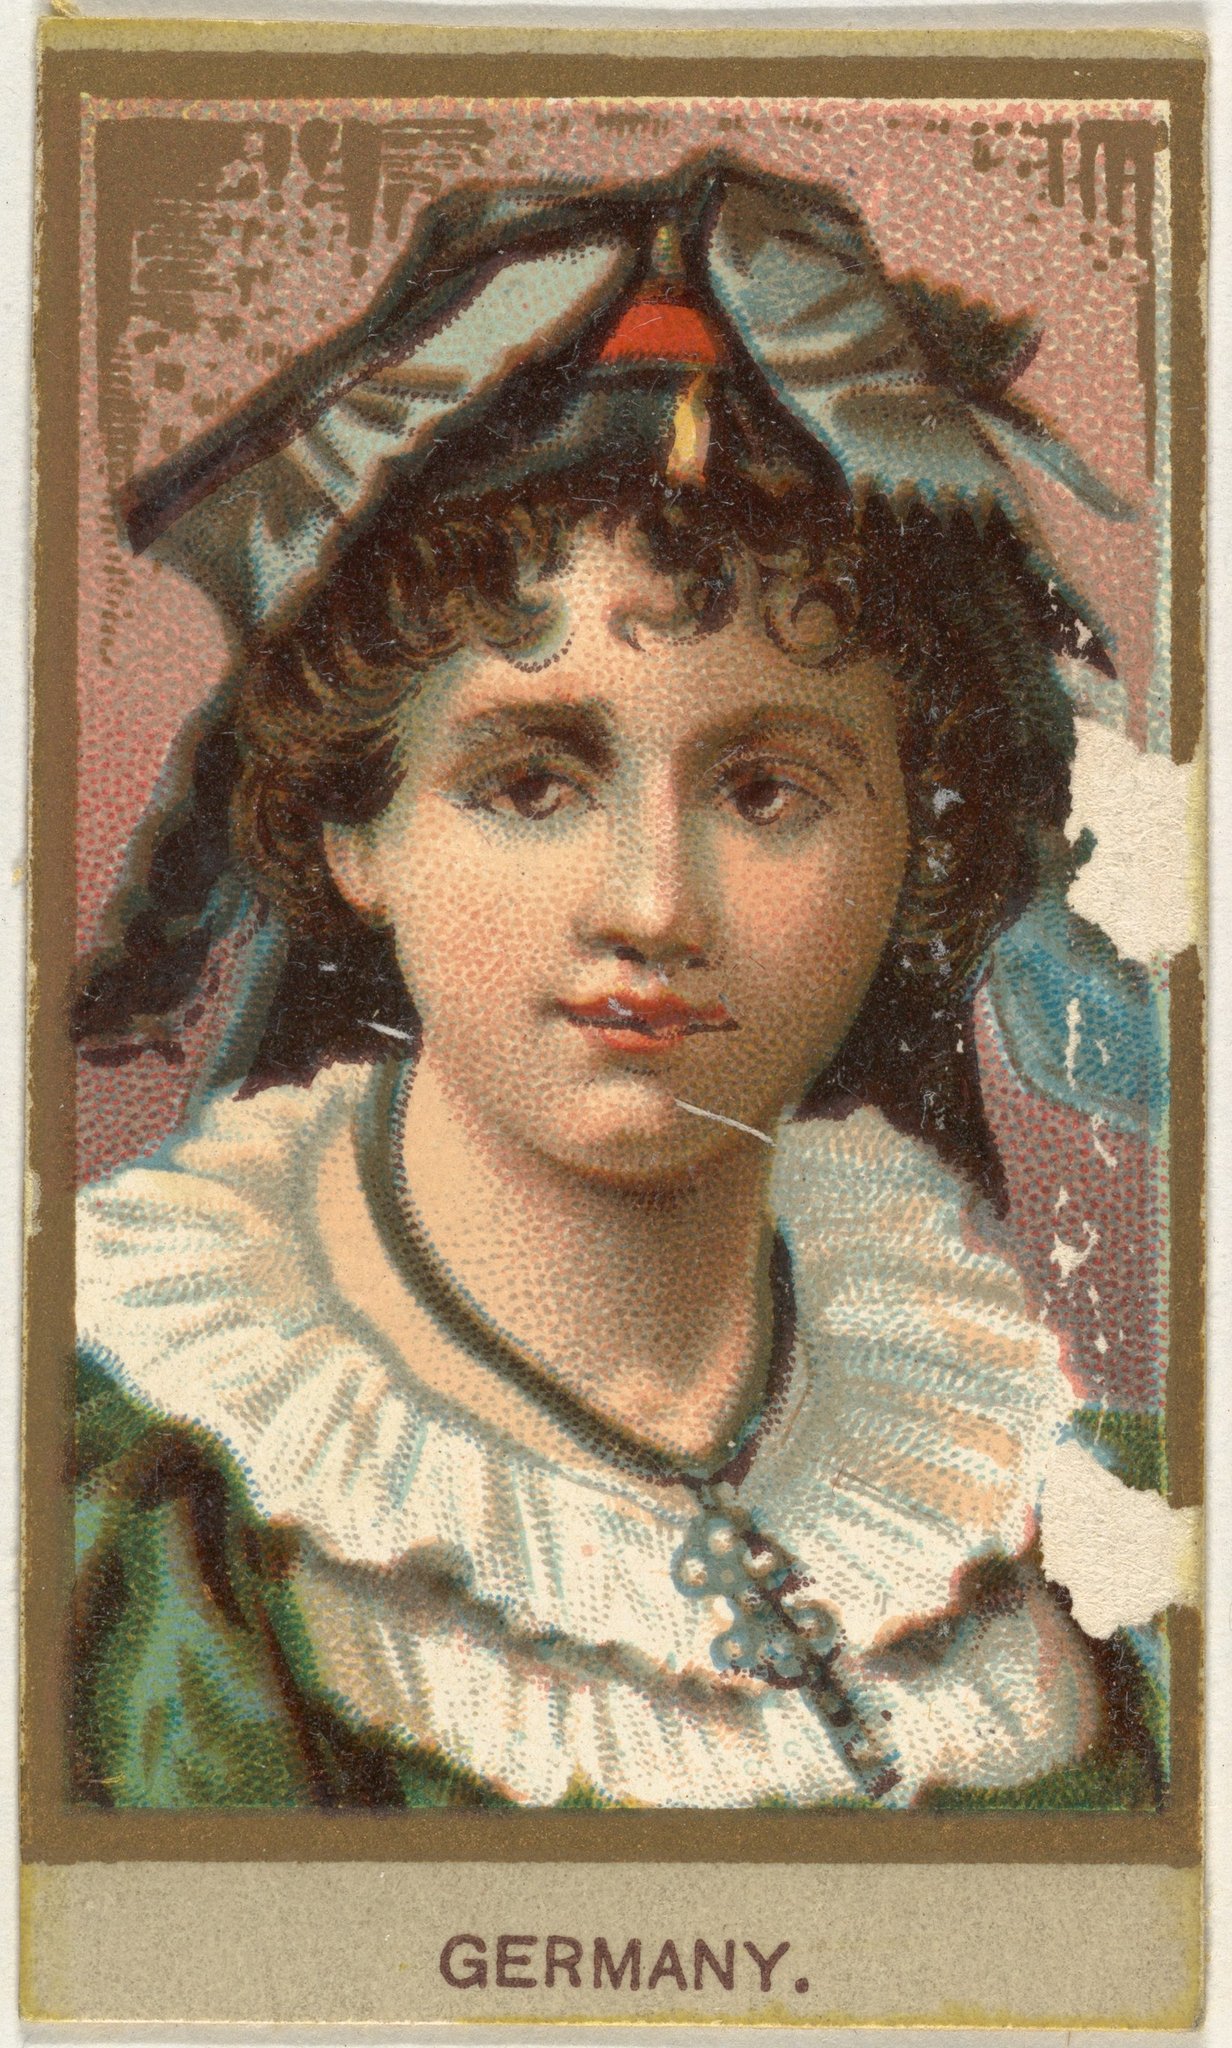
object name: print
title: Germany, from the Races of Mankind series (T181) issued by Abdul Cigarettes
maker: abdul cigarettes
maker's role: publisher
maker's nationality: american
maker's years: 1881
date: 1881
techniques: color lithograph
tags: portraits,women